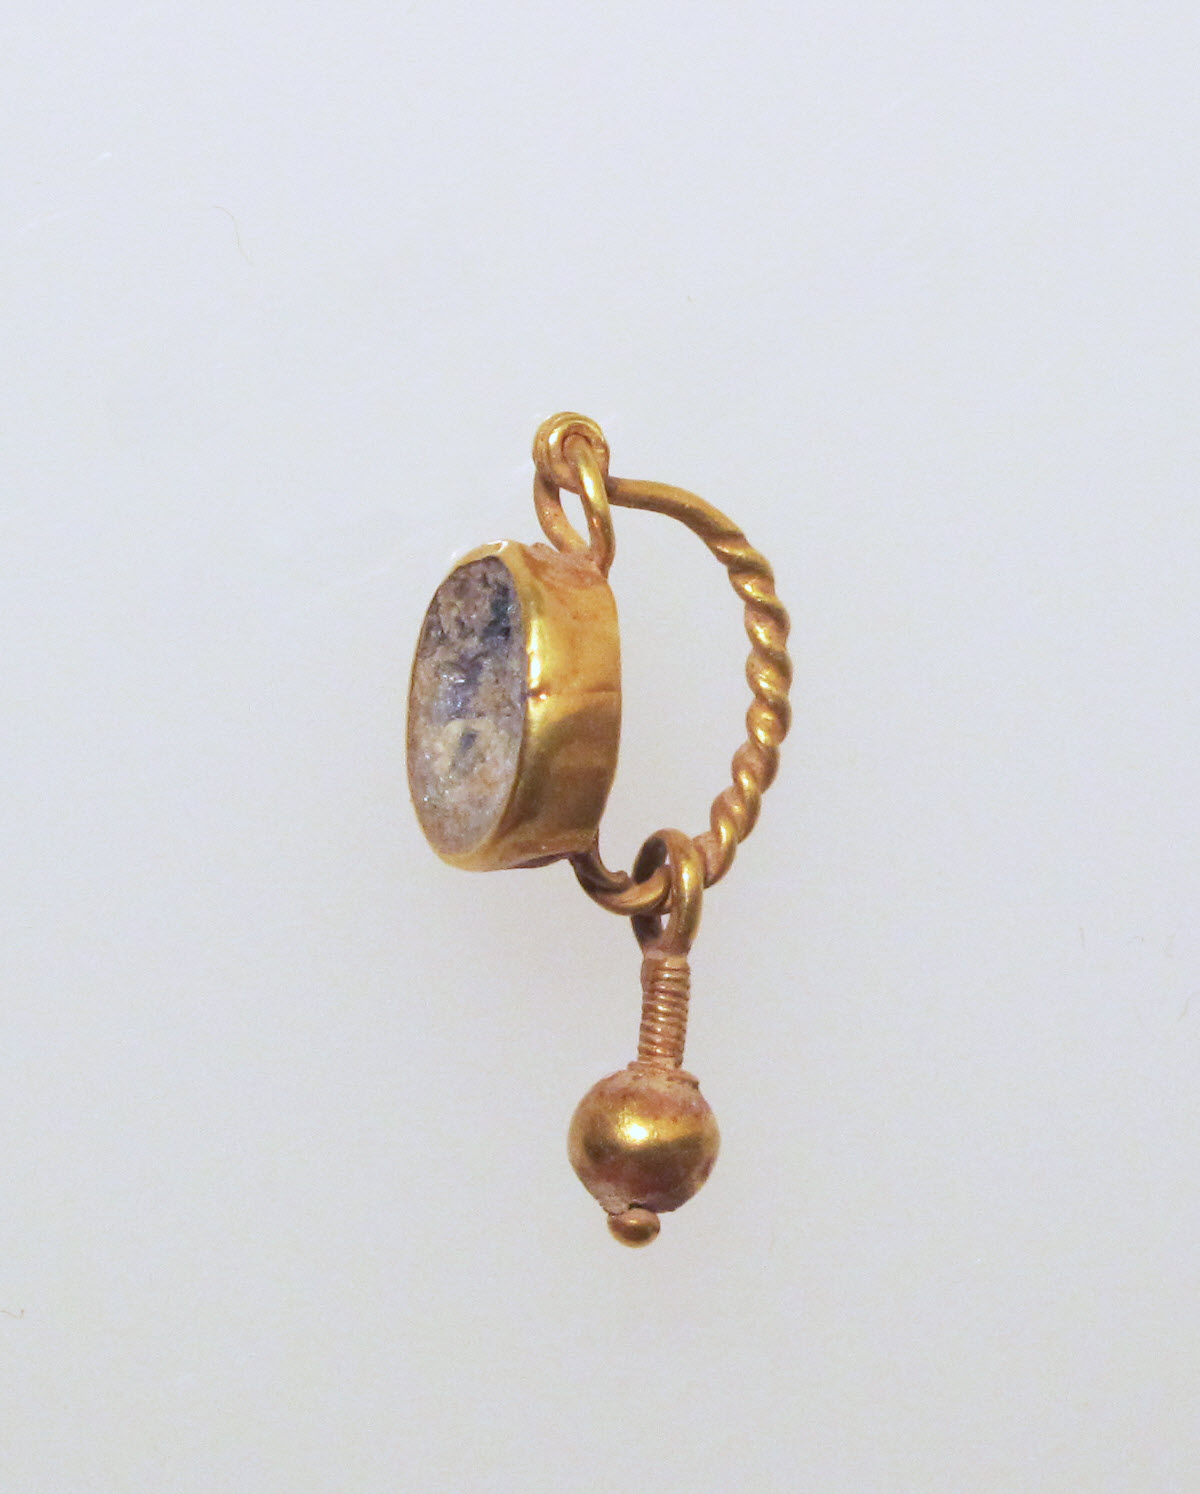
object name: earring hook type with ball pendant and paste setting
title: Earring with ball pendant and paste setting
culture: roman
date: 1-200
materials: glass, gold, paste